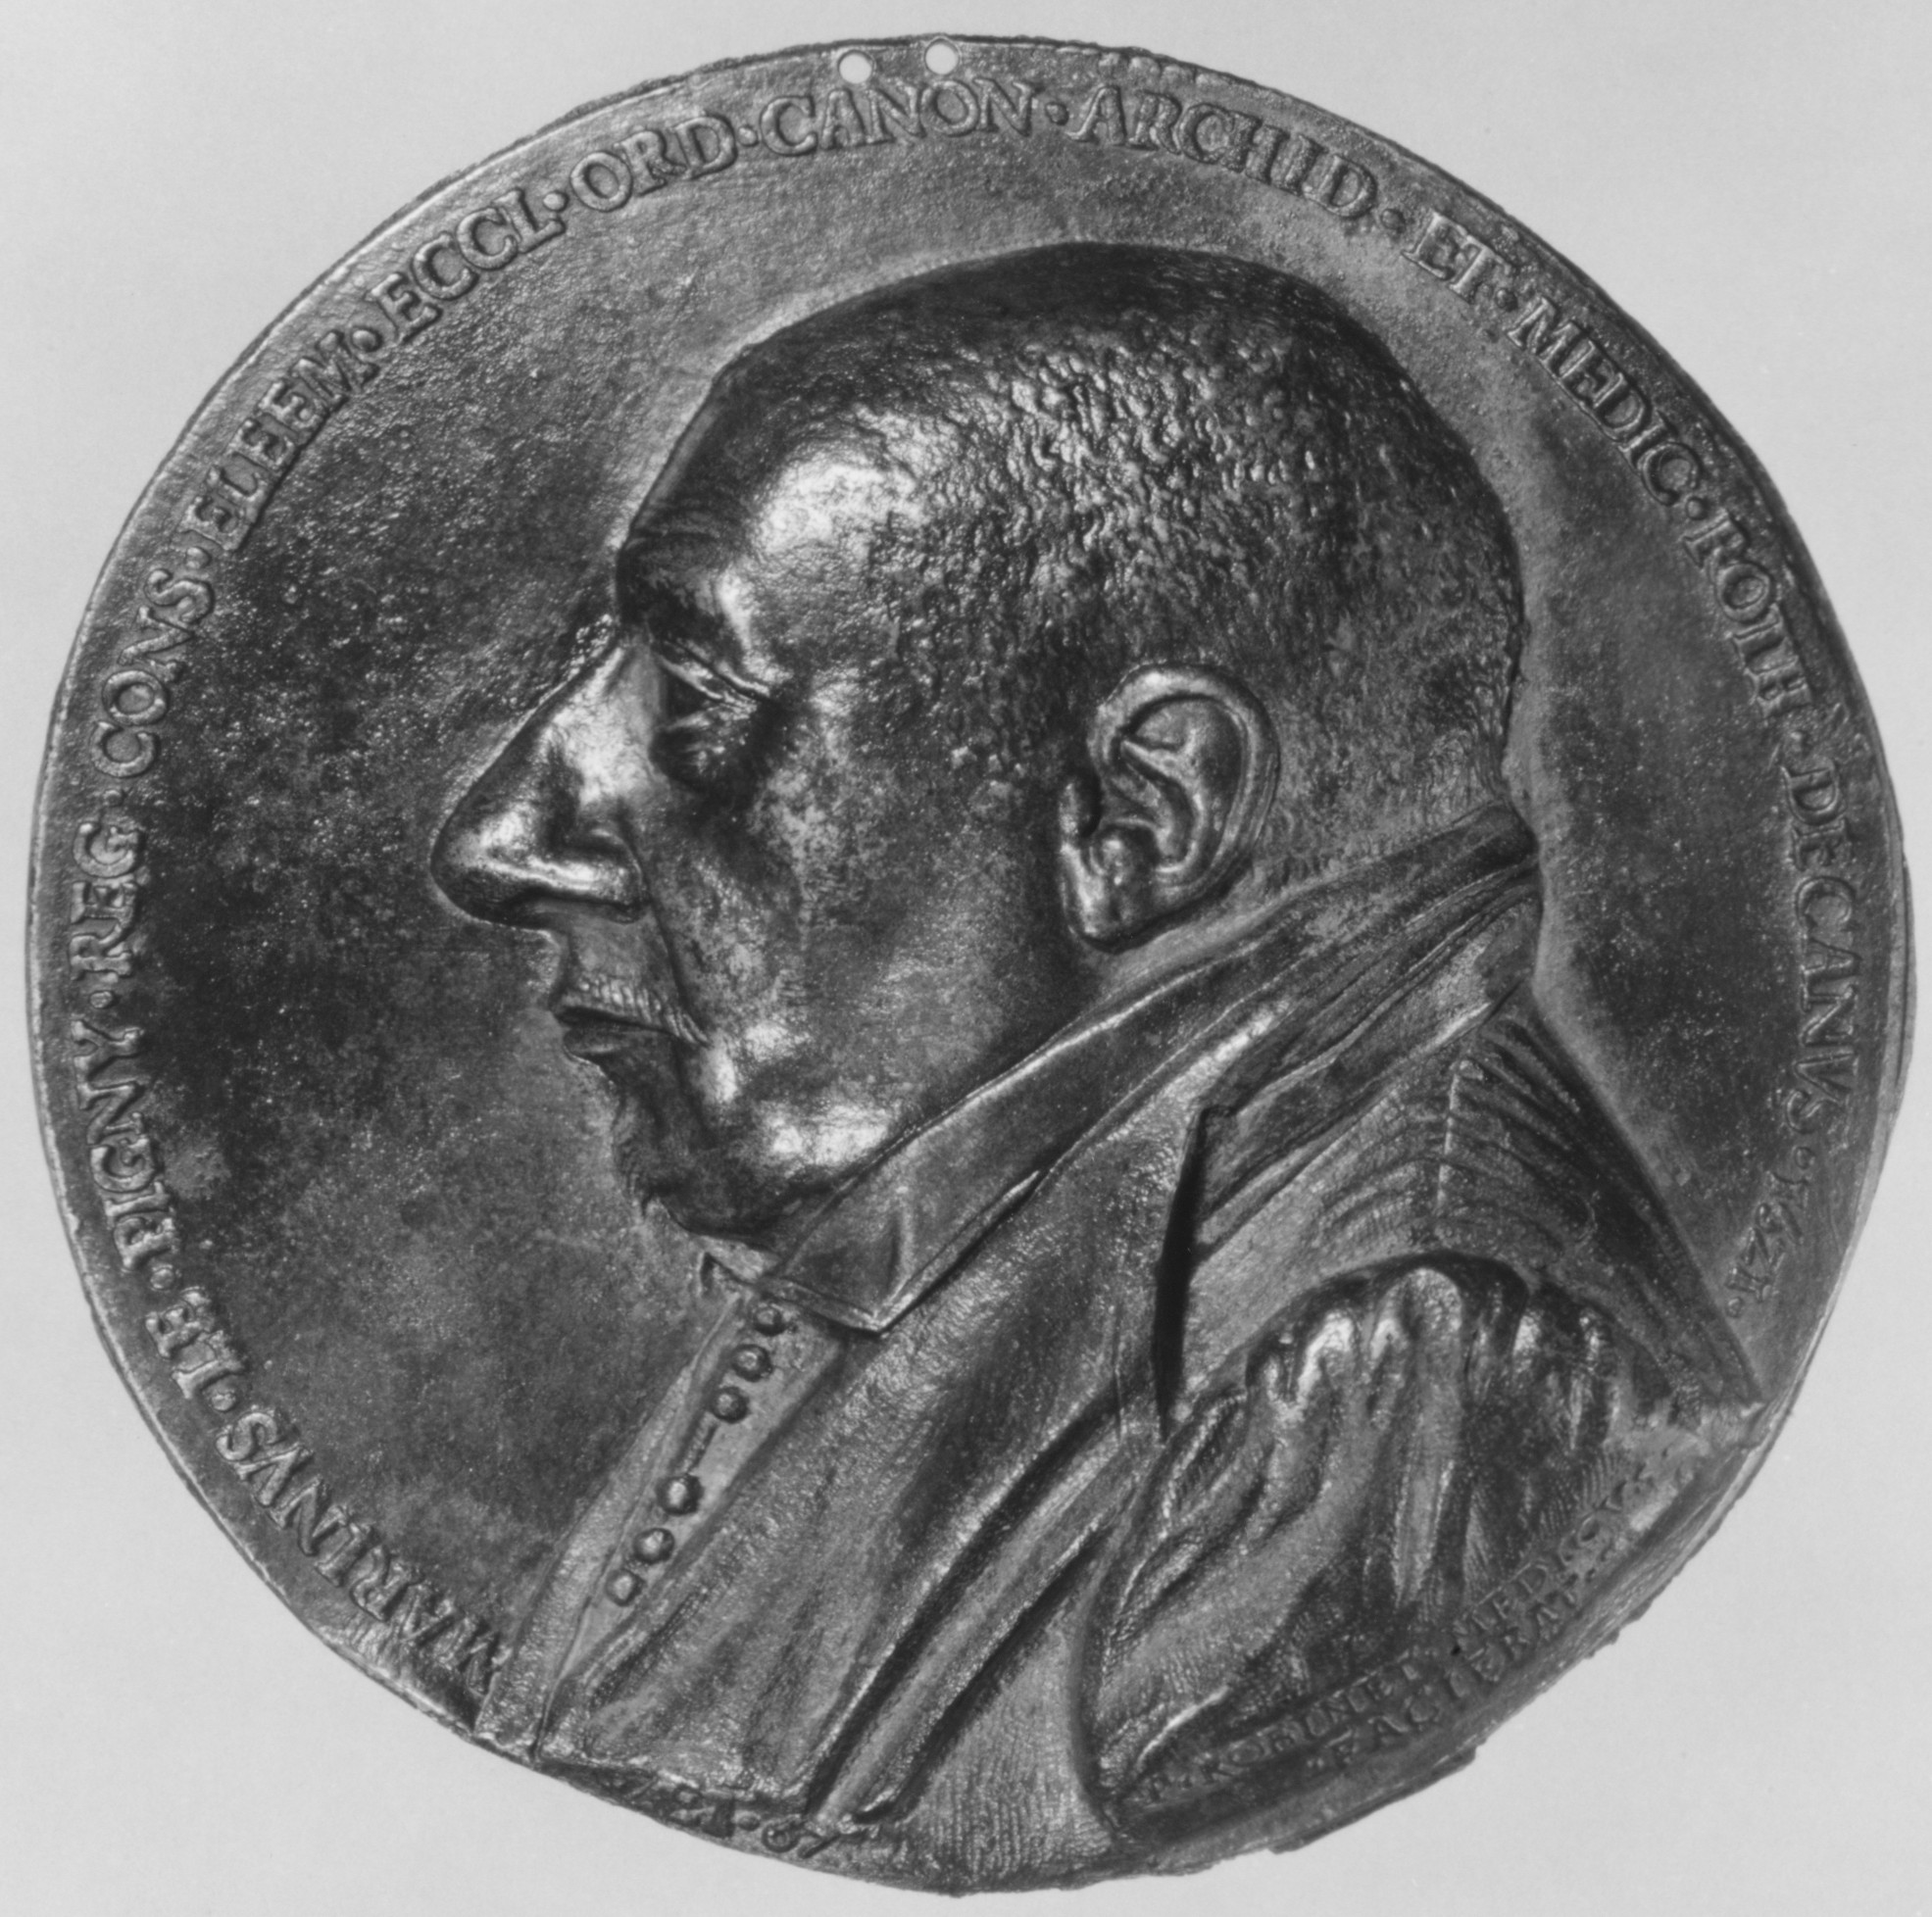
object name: medal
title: Marin Le Pigny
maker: pierre robinet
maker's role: artist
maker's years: 1575-1675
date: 1621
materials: bronze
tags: men,profiles